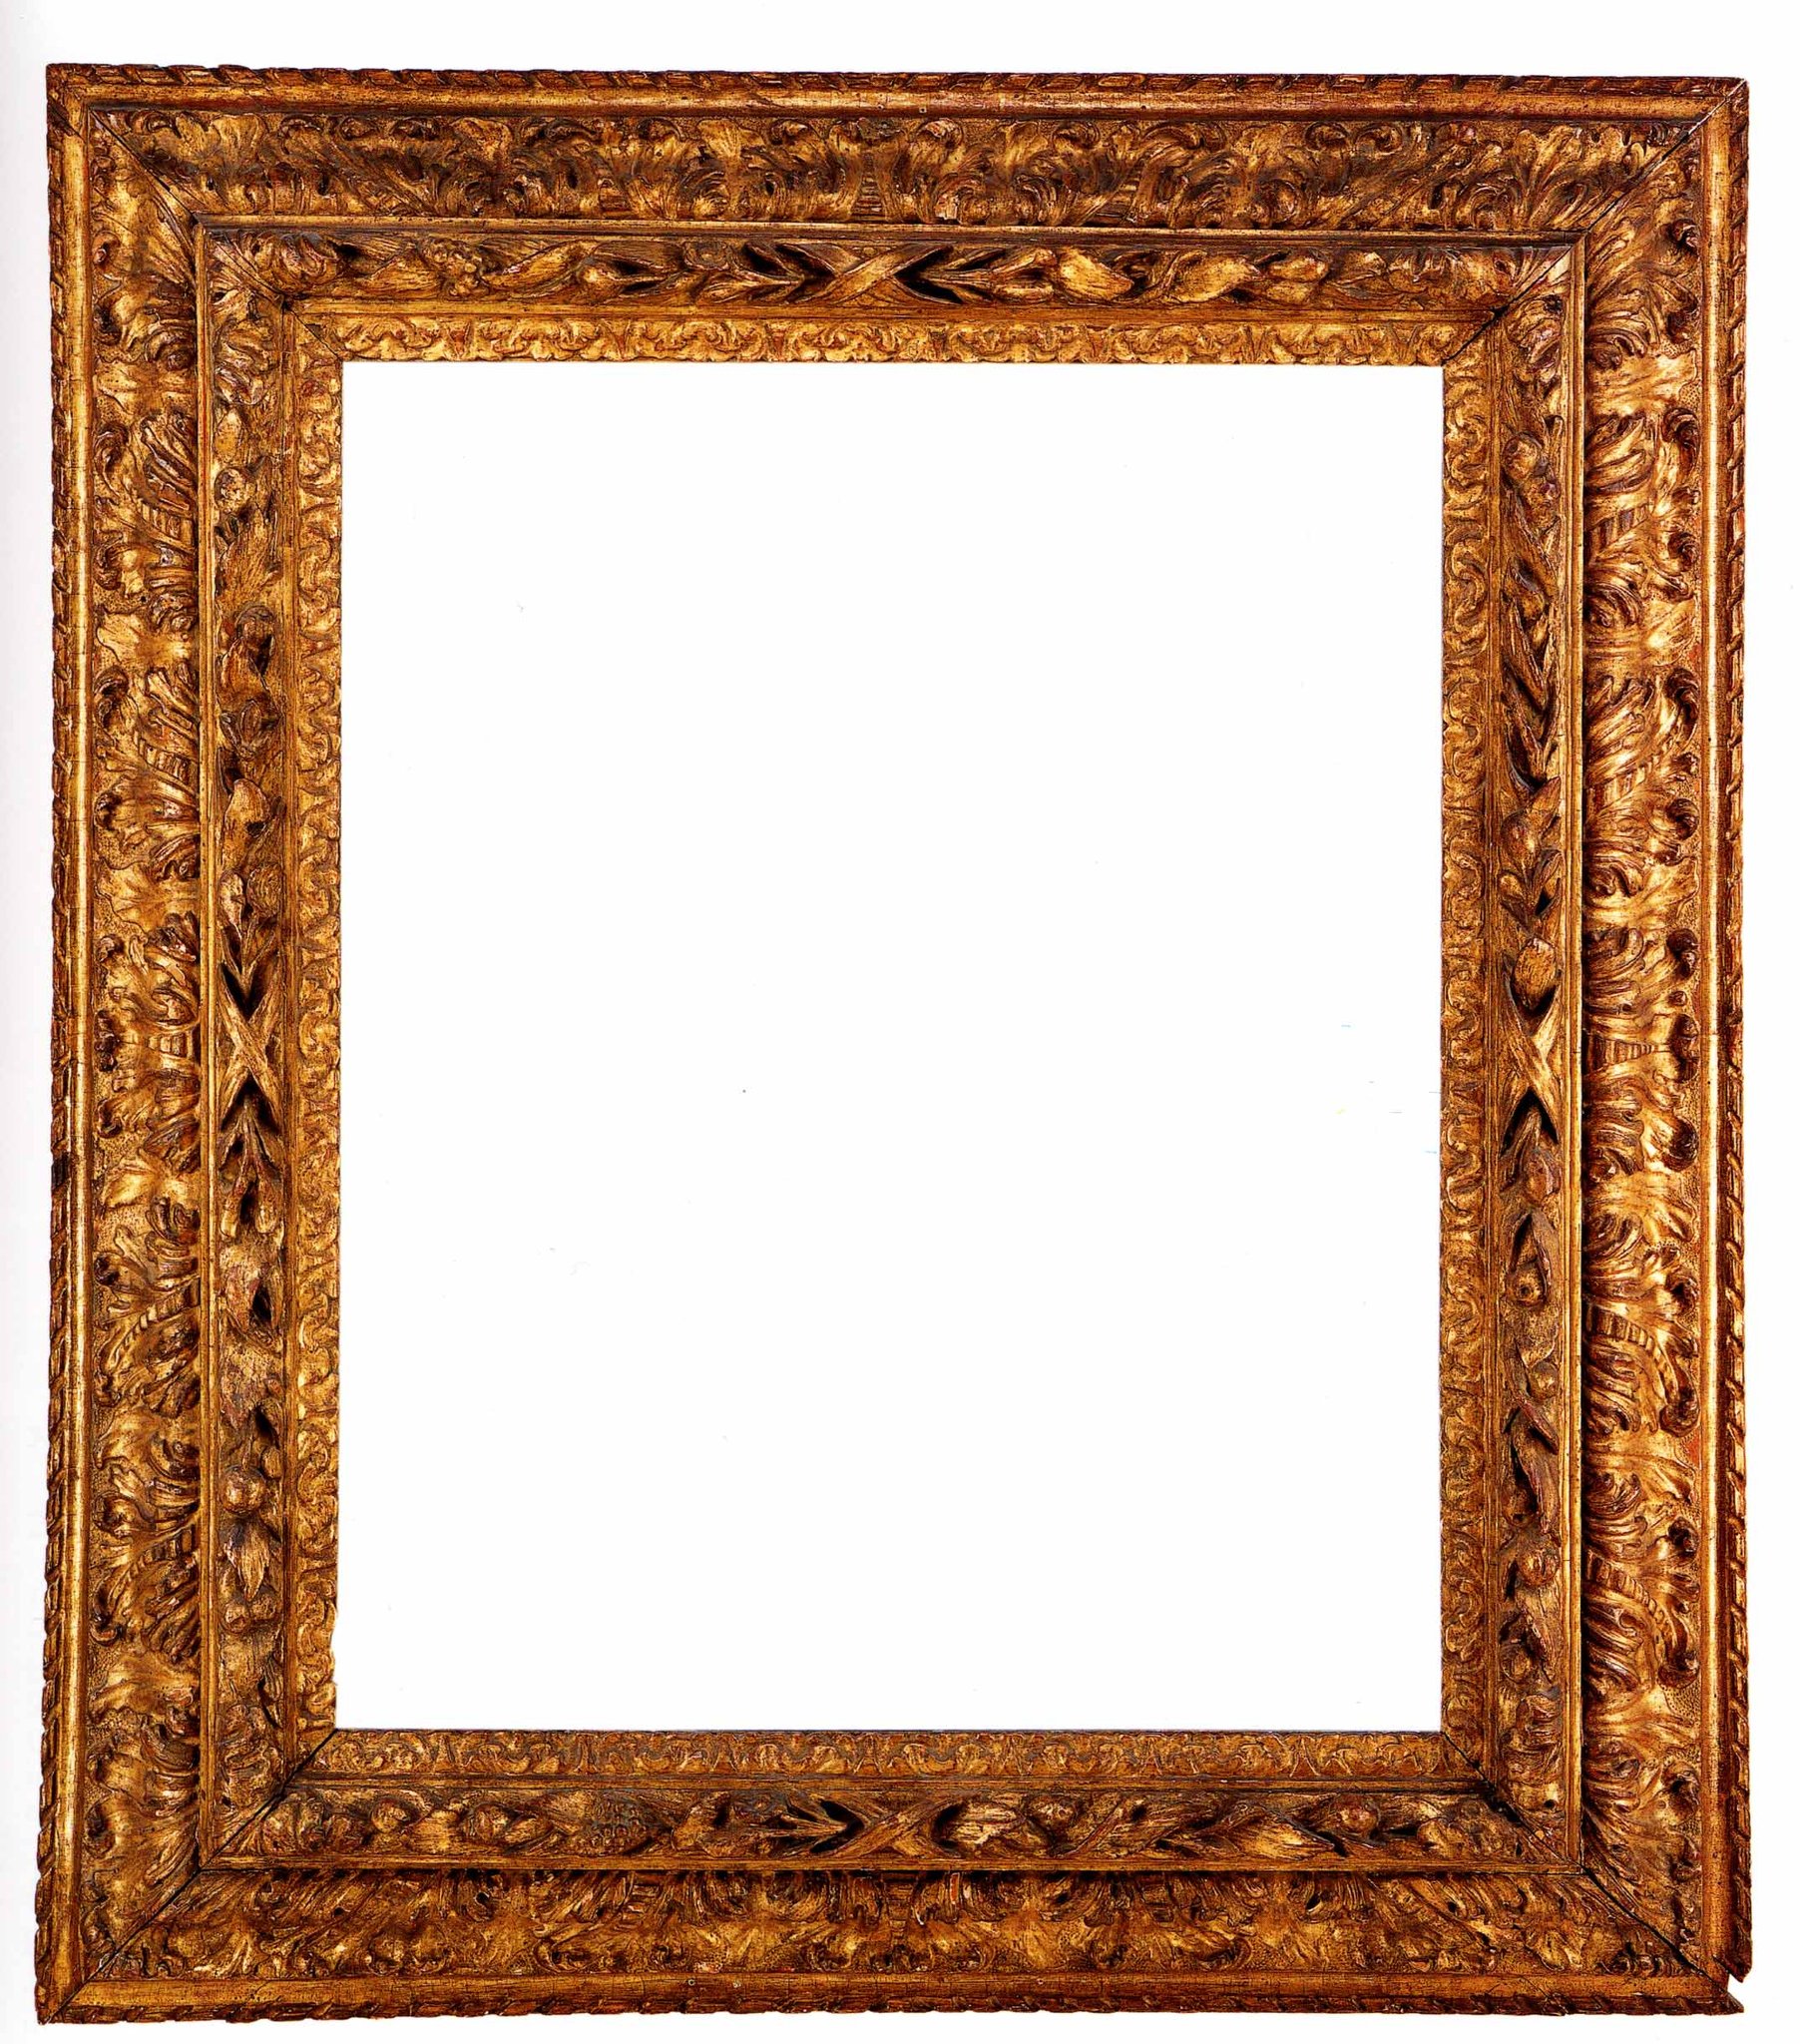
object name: frame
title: Reverse frame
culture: bolognese or southern italian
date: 1640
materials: gilt, wood